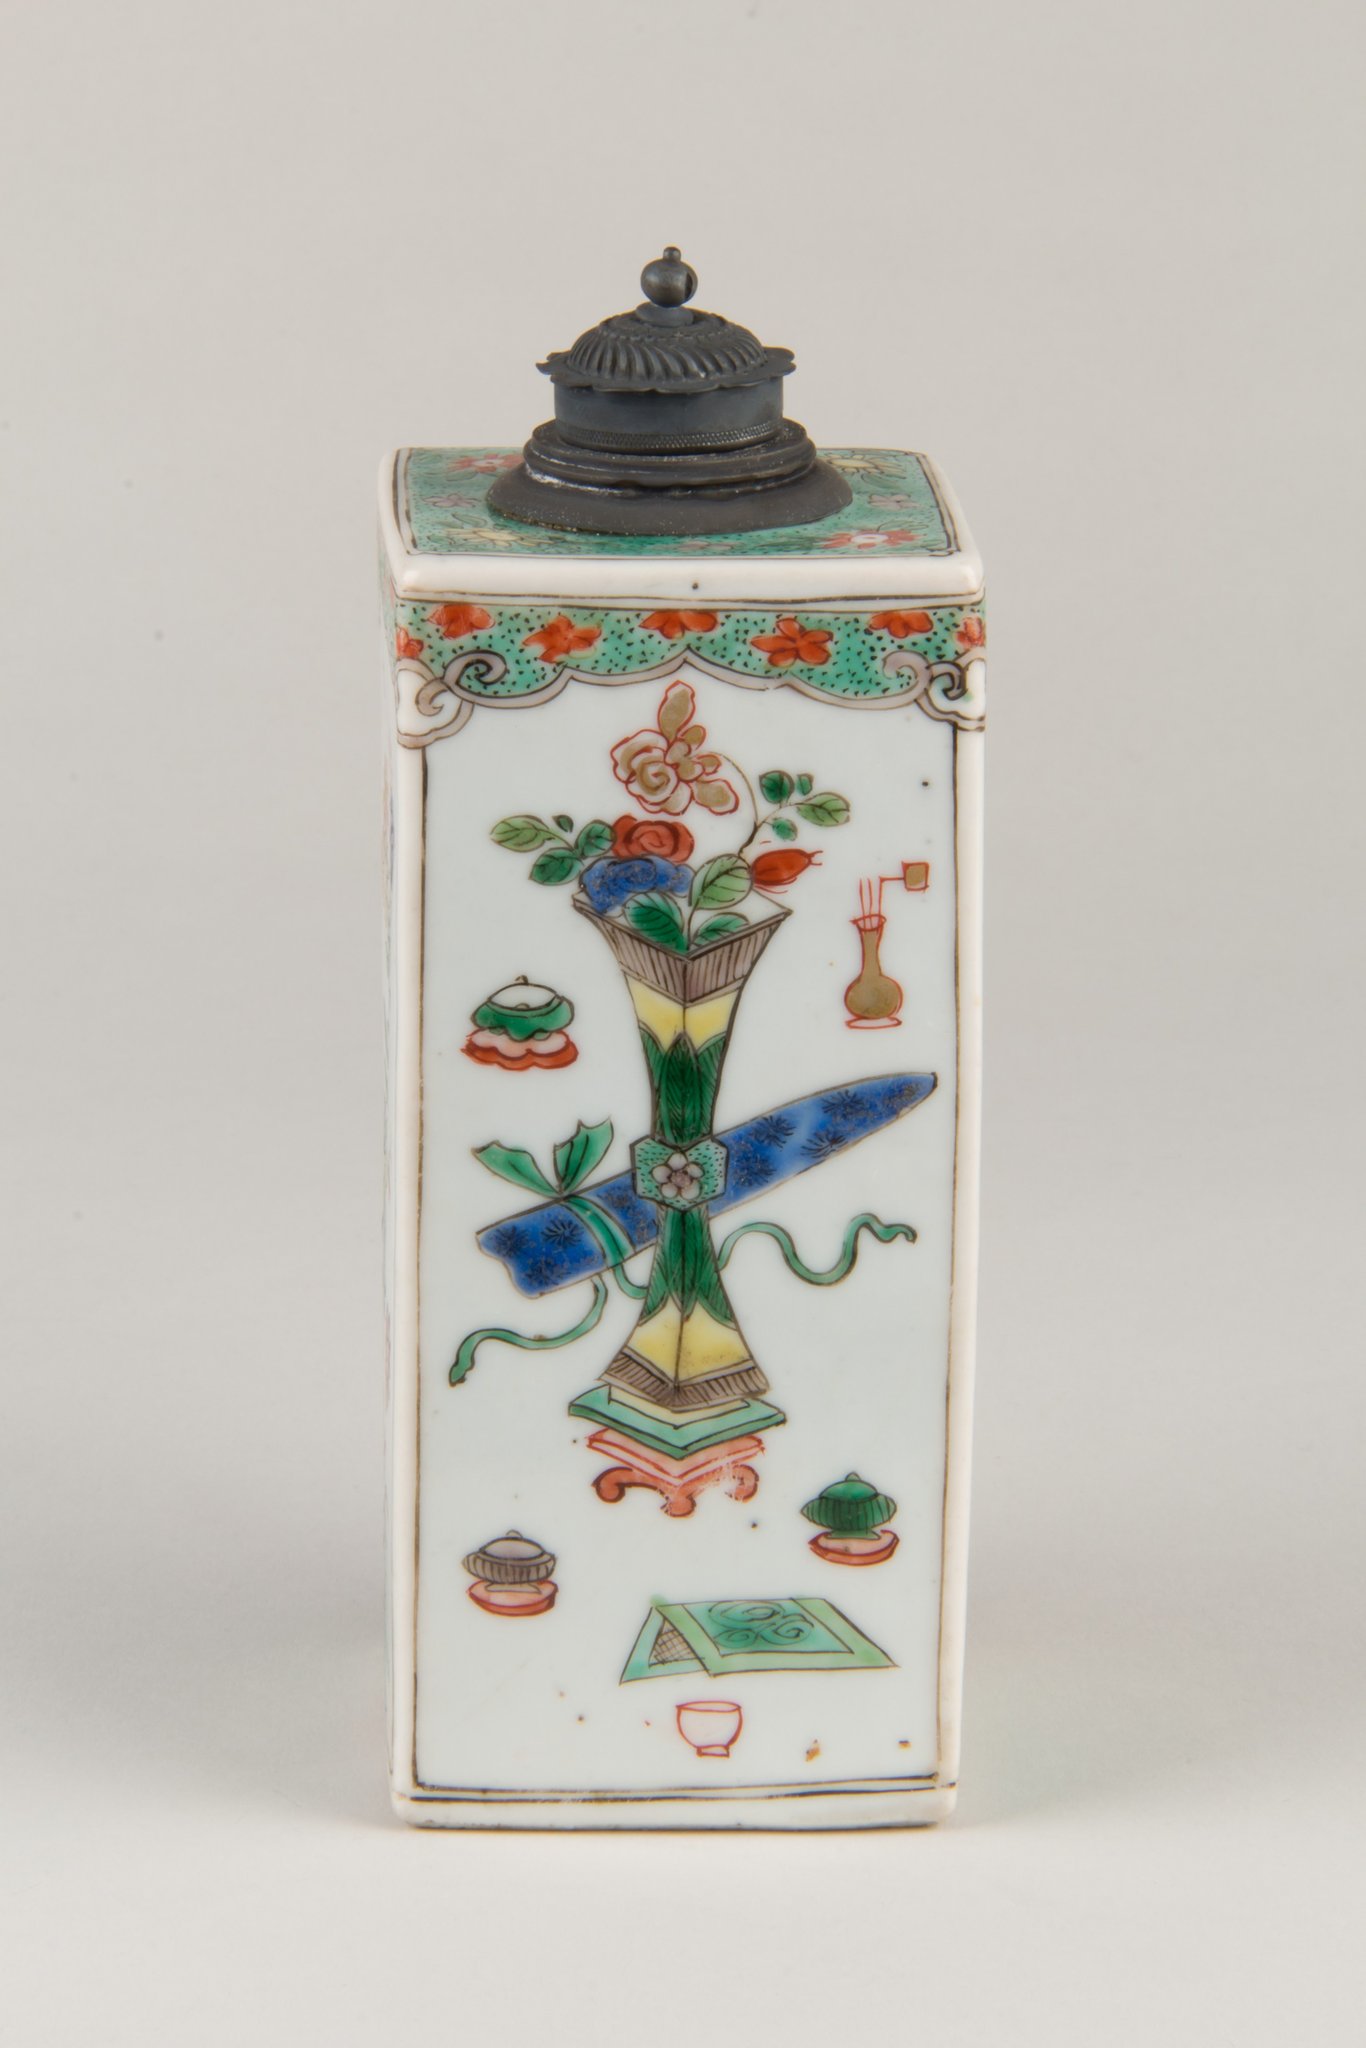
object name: vase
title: Square vase with archaisitic vessels and flowers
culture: chinese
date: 1667-1733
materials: enamel, porcelain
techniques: overglaze, painting, polychrome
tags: flowers